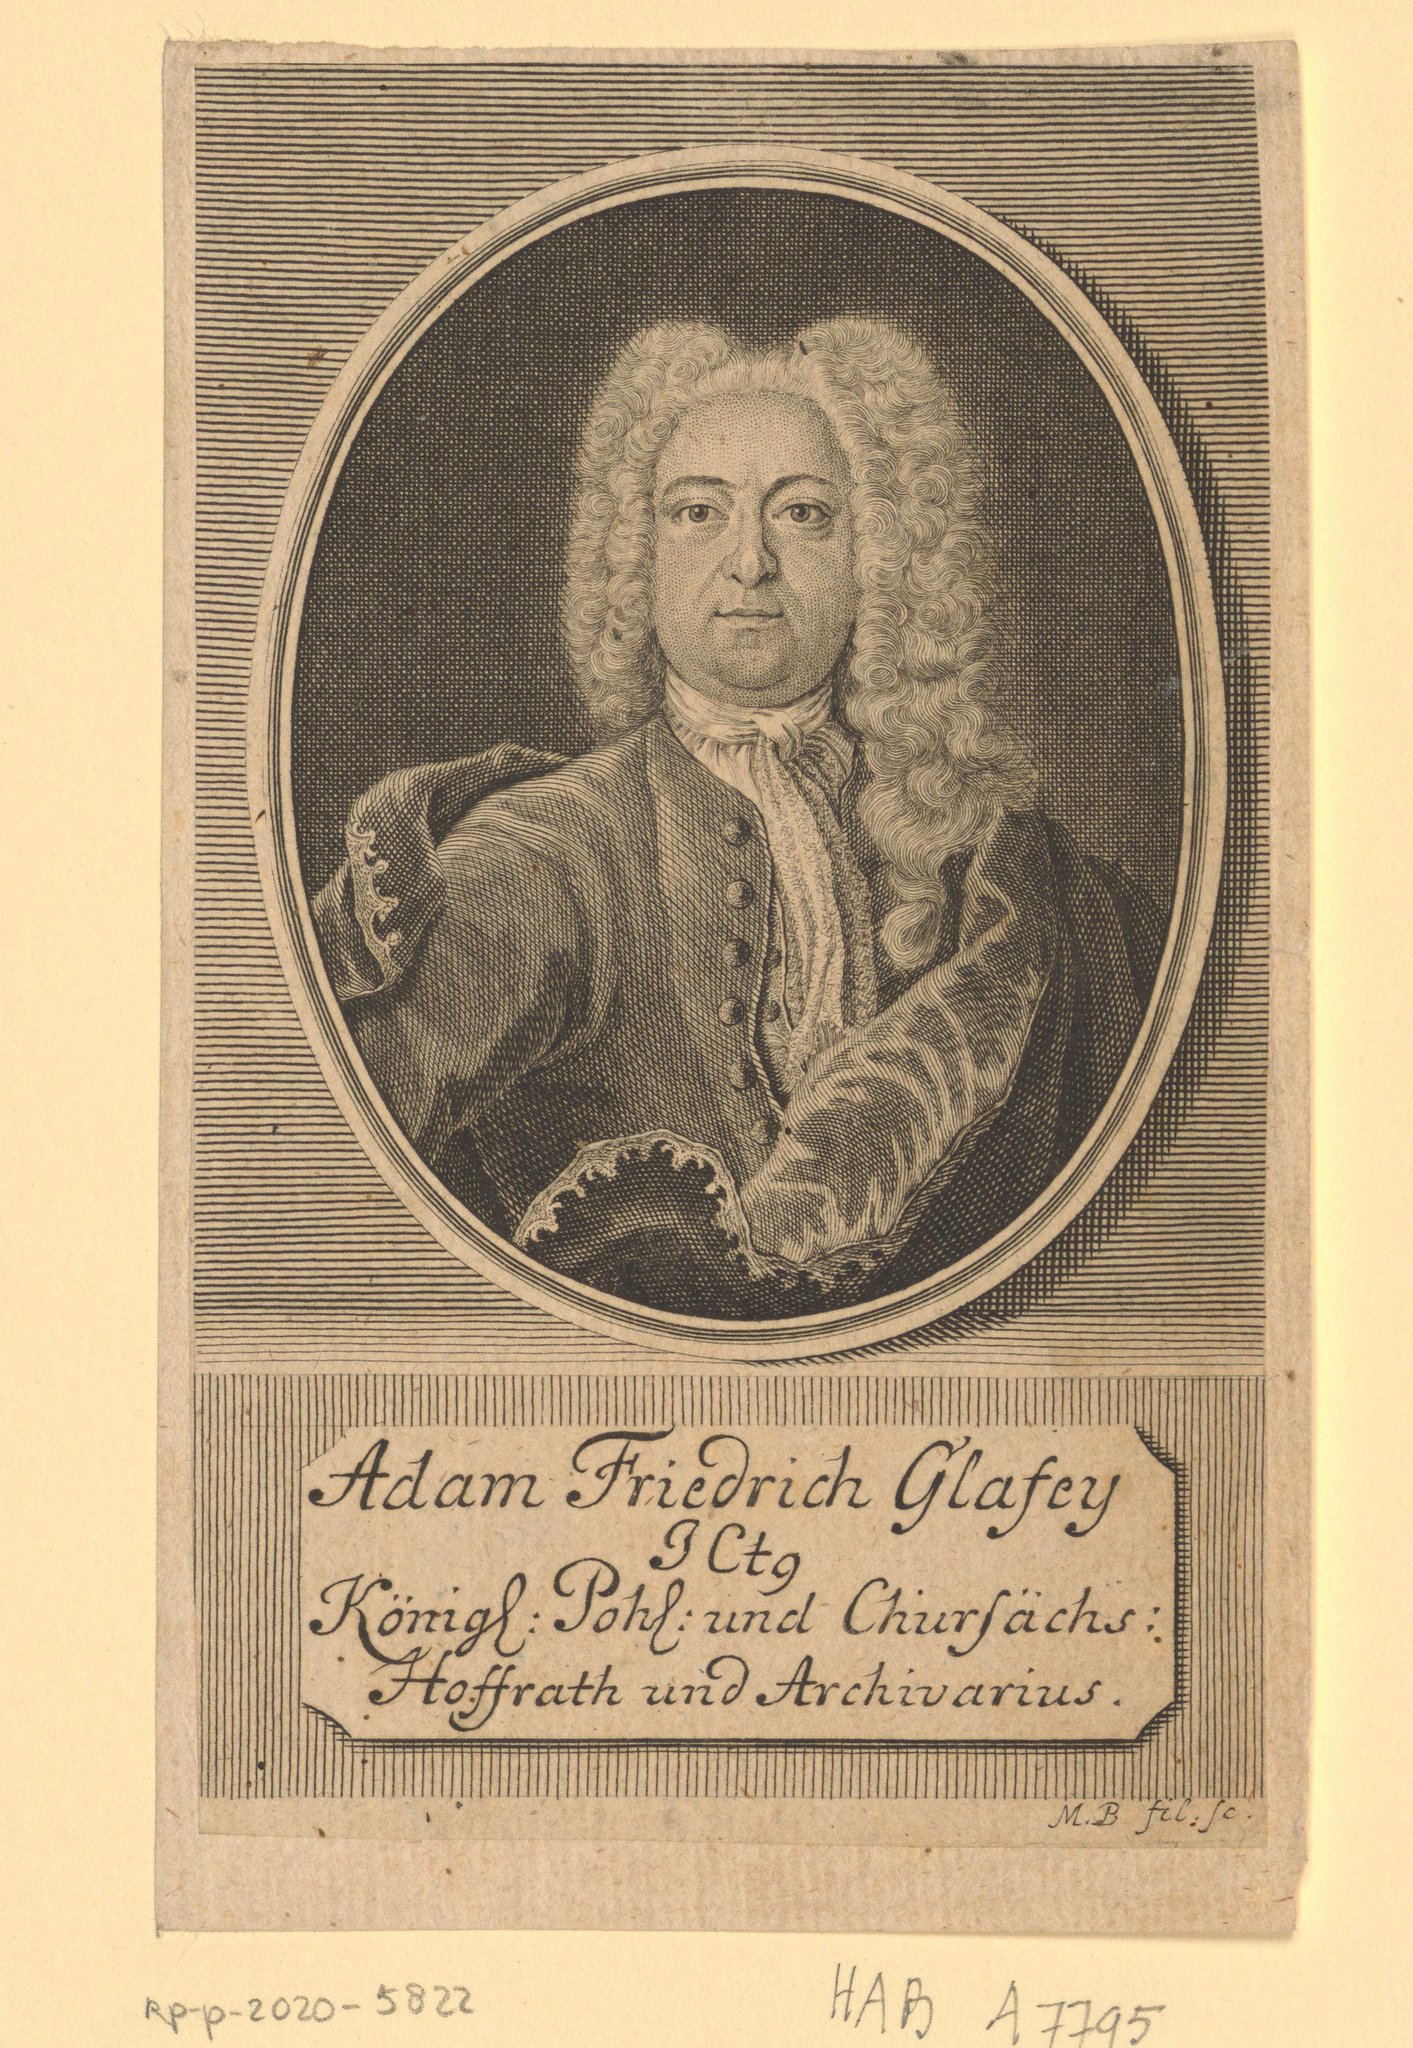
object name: print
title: Portret van Adam Friedrich Glafey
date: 1733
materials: paper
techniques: engraving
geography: leipzig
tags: historical persons, scholar, philosopher (+ portrait of scholar, scientist)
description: Prent uit: Deutsche Acta Eruditorum (...). Leipzig: Johann Gottlieb Gleditsch, 1733, dl. 179.